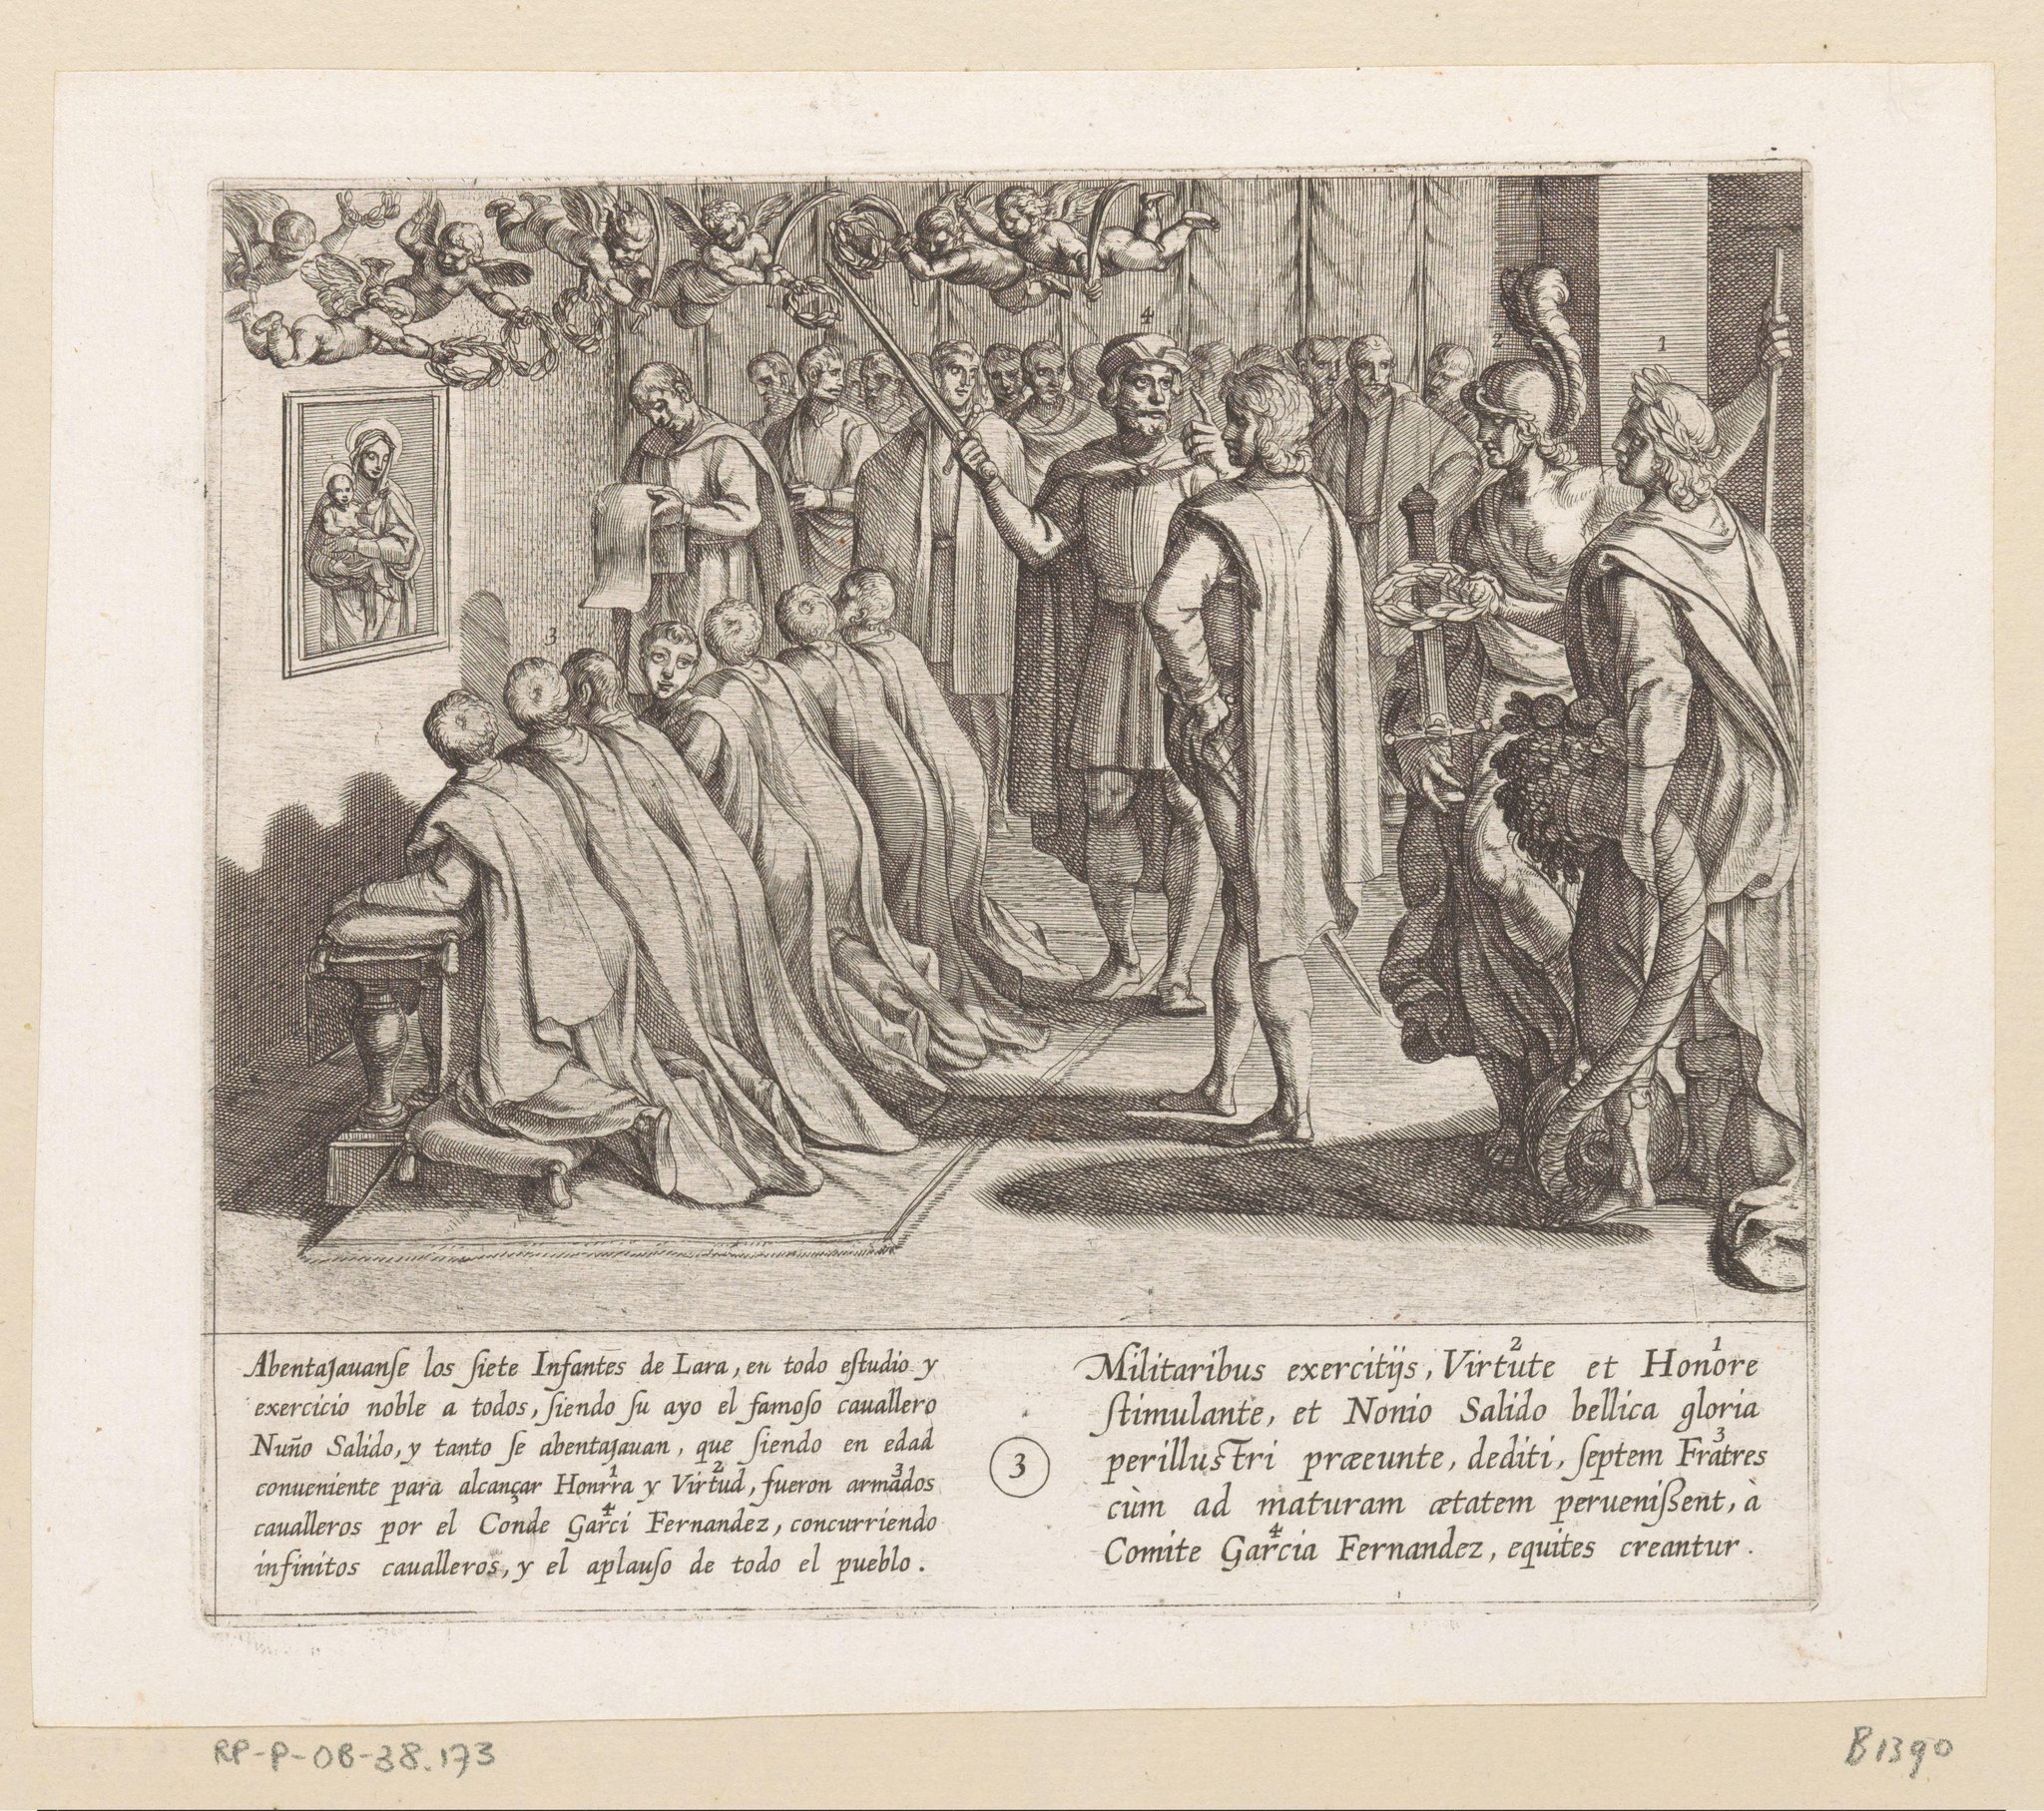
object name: print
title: Historia Septem Infantium de Lara/ Historia de los Siete Infantes de Lara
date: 1612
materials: paper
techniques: etching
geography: antwerp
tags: tales and fairy tales, becoming a knight, knighting, cupids: 'amores', 'amoretti', 'putti'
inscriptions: collector's mark: Lugt 240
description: Deze prent maakt deel uit van een reeks van 40 prenten (+ titelprent) met voorstellingen uit het volksverhaal over de zeven infanten van Lara.